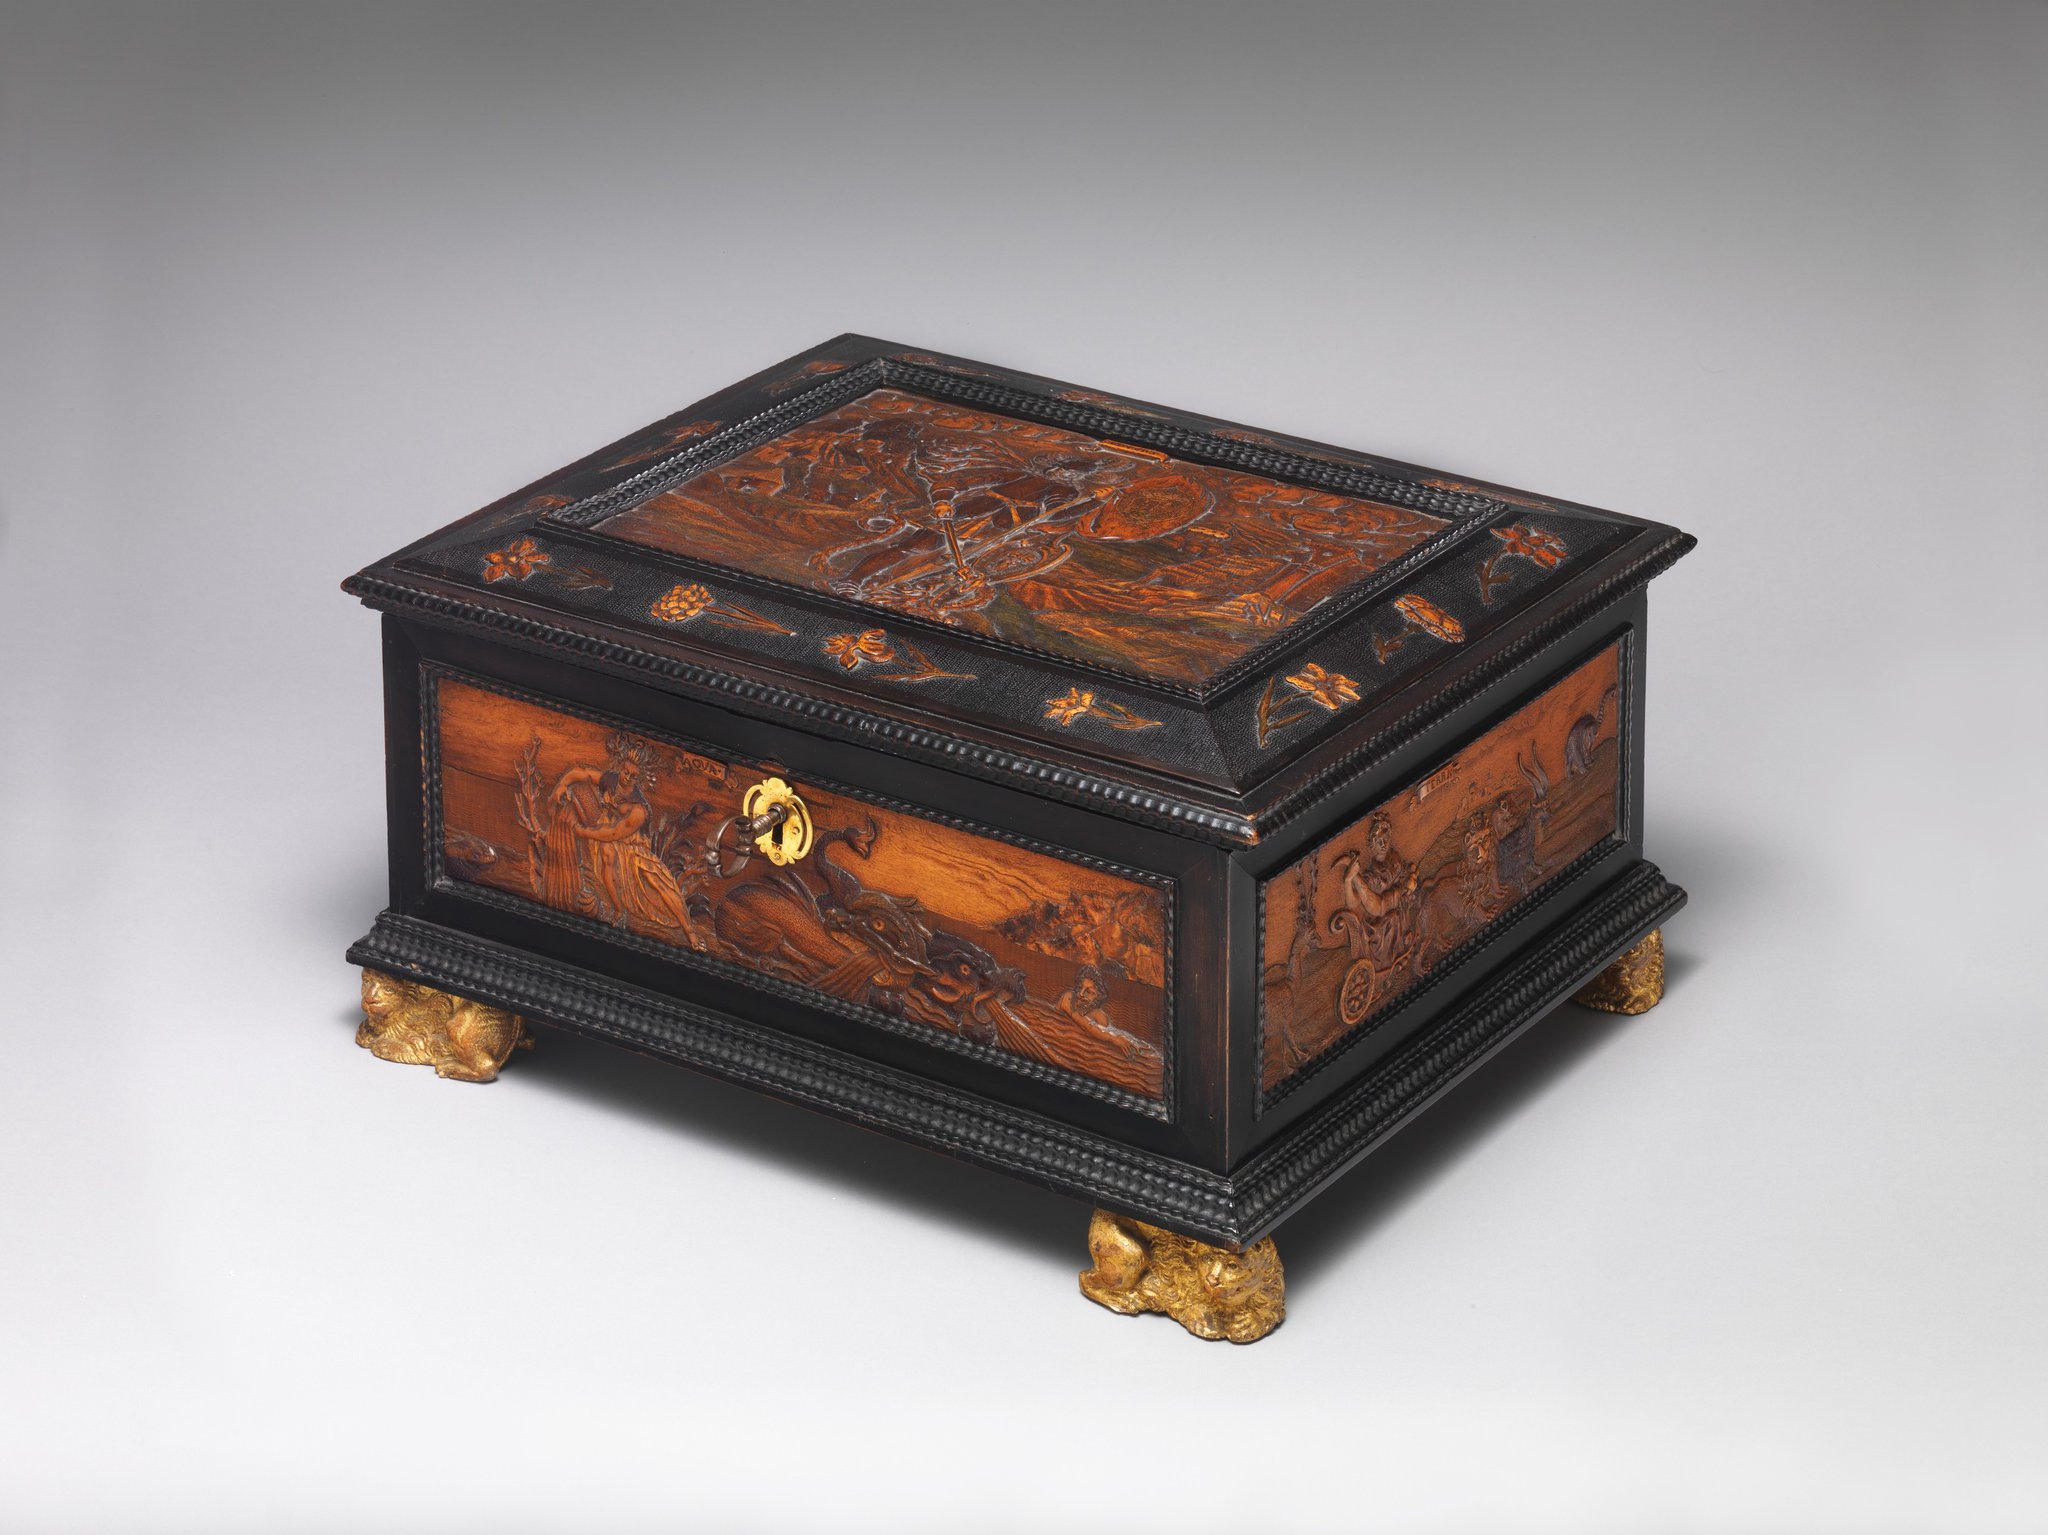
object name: casket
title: Casket with allegories of the Four Elements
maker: adam eck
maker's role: maker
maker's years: 1604-1664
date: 1650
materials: iron, paper, wood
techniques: carving, stain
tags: dragons,lions,chariots